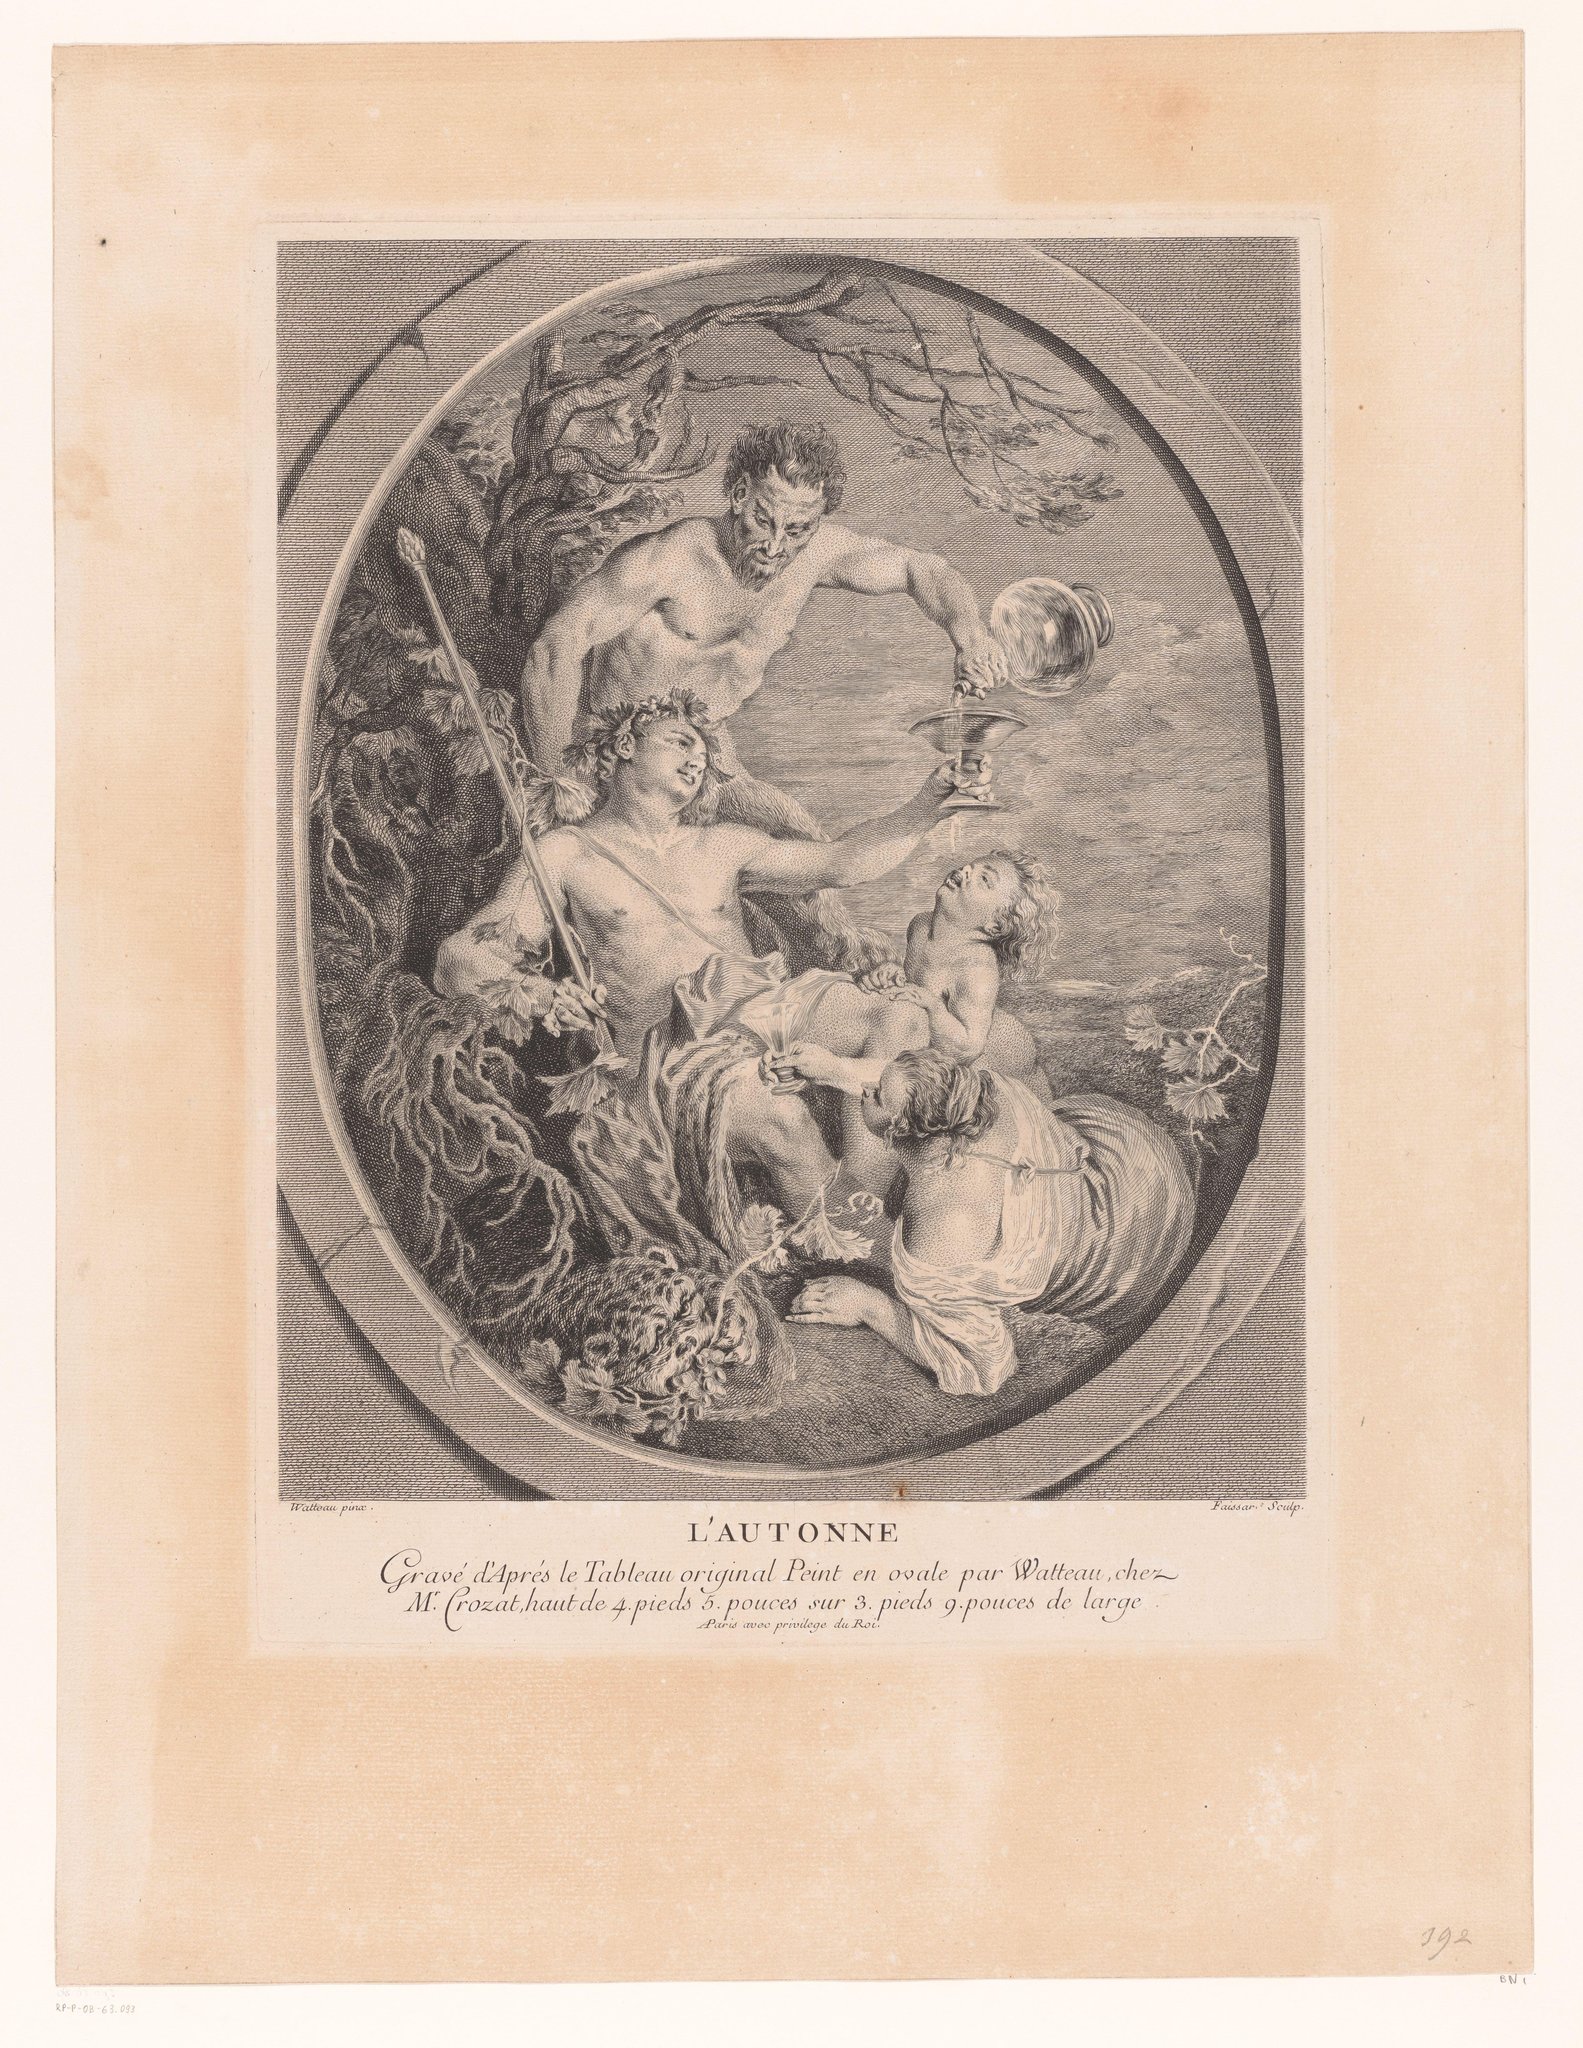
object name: print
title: L'Autonne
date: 1726-1735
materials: paper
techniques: engraving, etching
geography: france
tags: maenad(s), female bacchant(es), male bacchant(es), autumn, fall, 'autumnus'; 'autunno' (ripa)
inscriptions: collector's mark: Lugt 2228